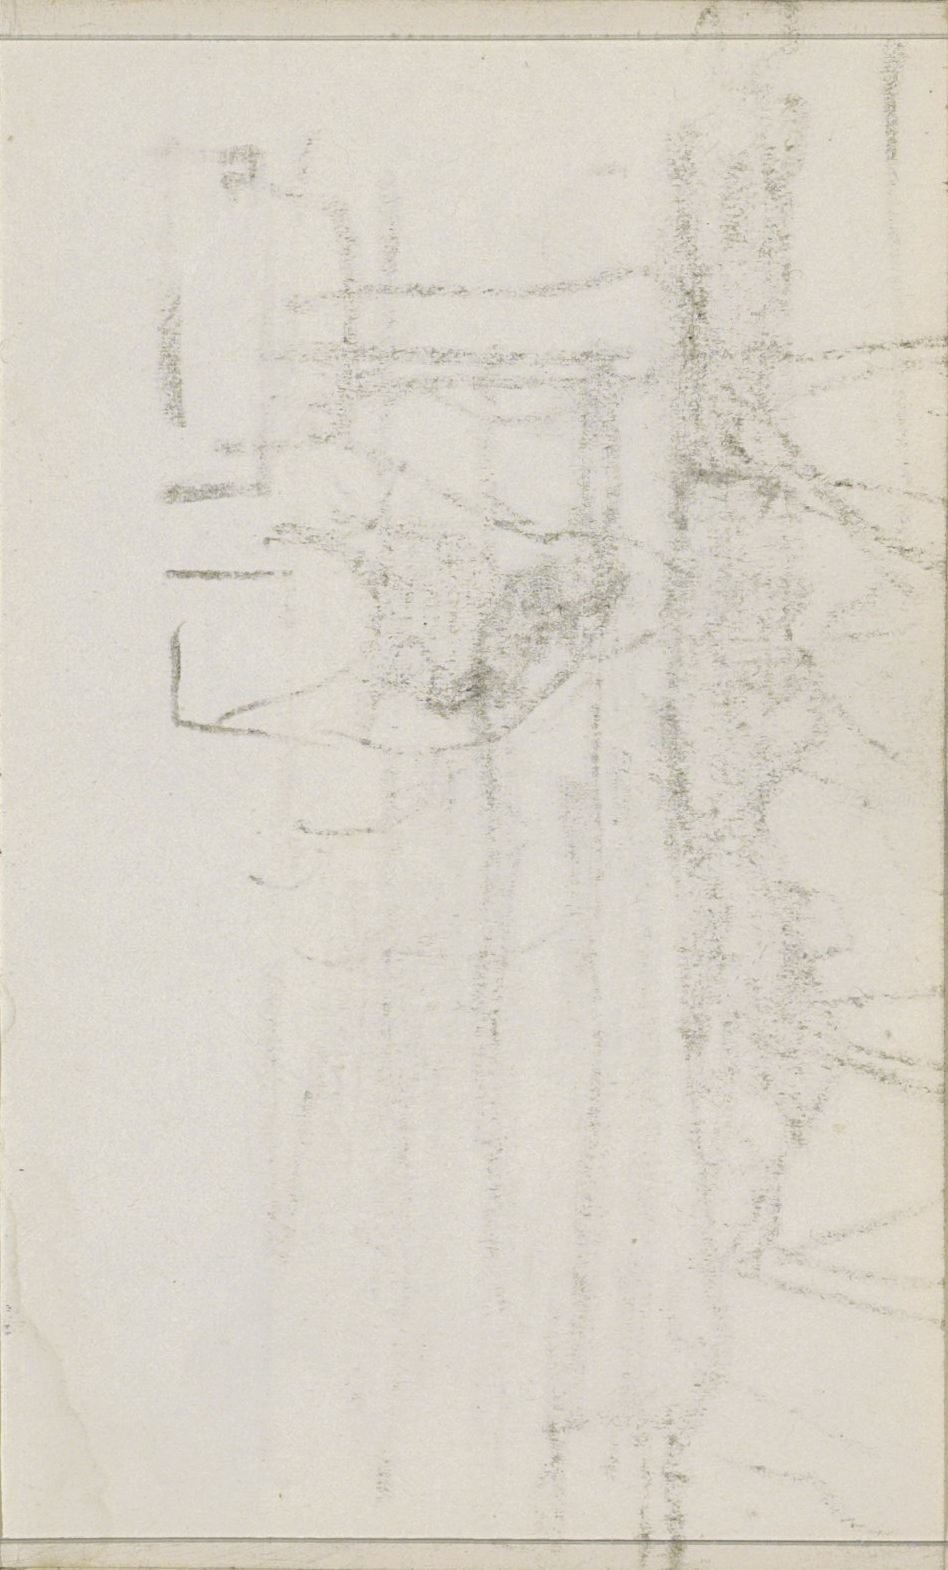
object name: sketchbook leaf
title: Abklatsch van de krijttekening op pagina 15 verso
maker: anton mauve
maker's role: draughtsman, painter, print maker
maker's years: 1838-1888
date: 1848-1888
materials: paper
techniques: printmaking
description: Blad 16 recto uit een schetsboek met 53 bladen.